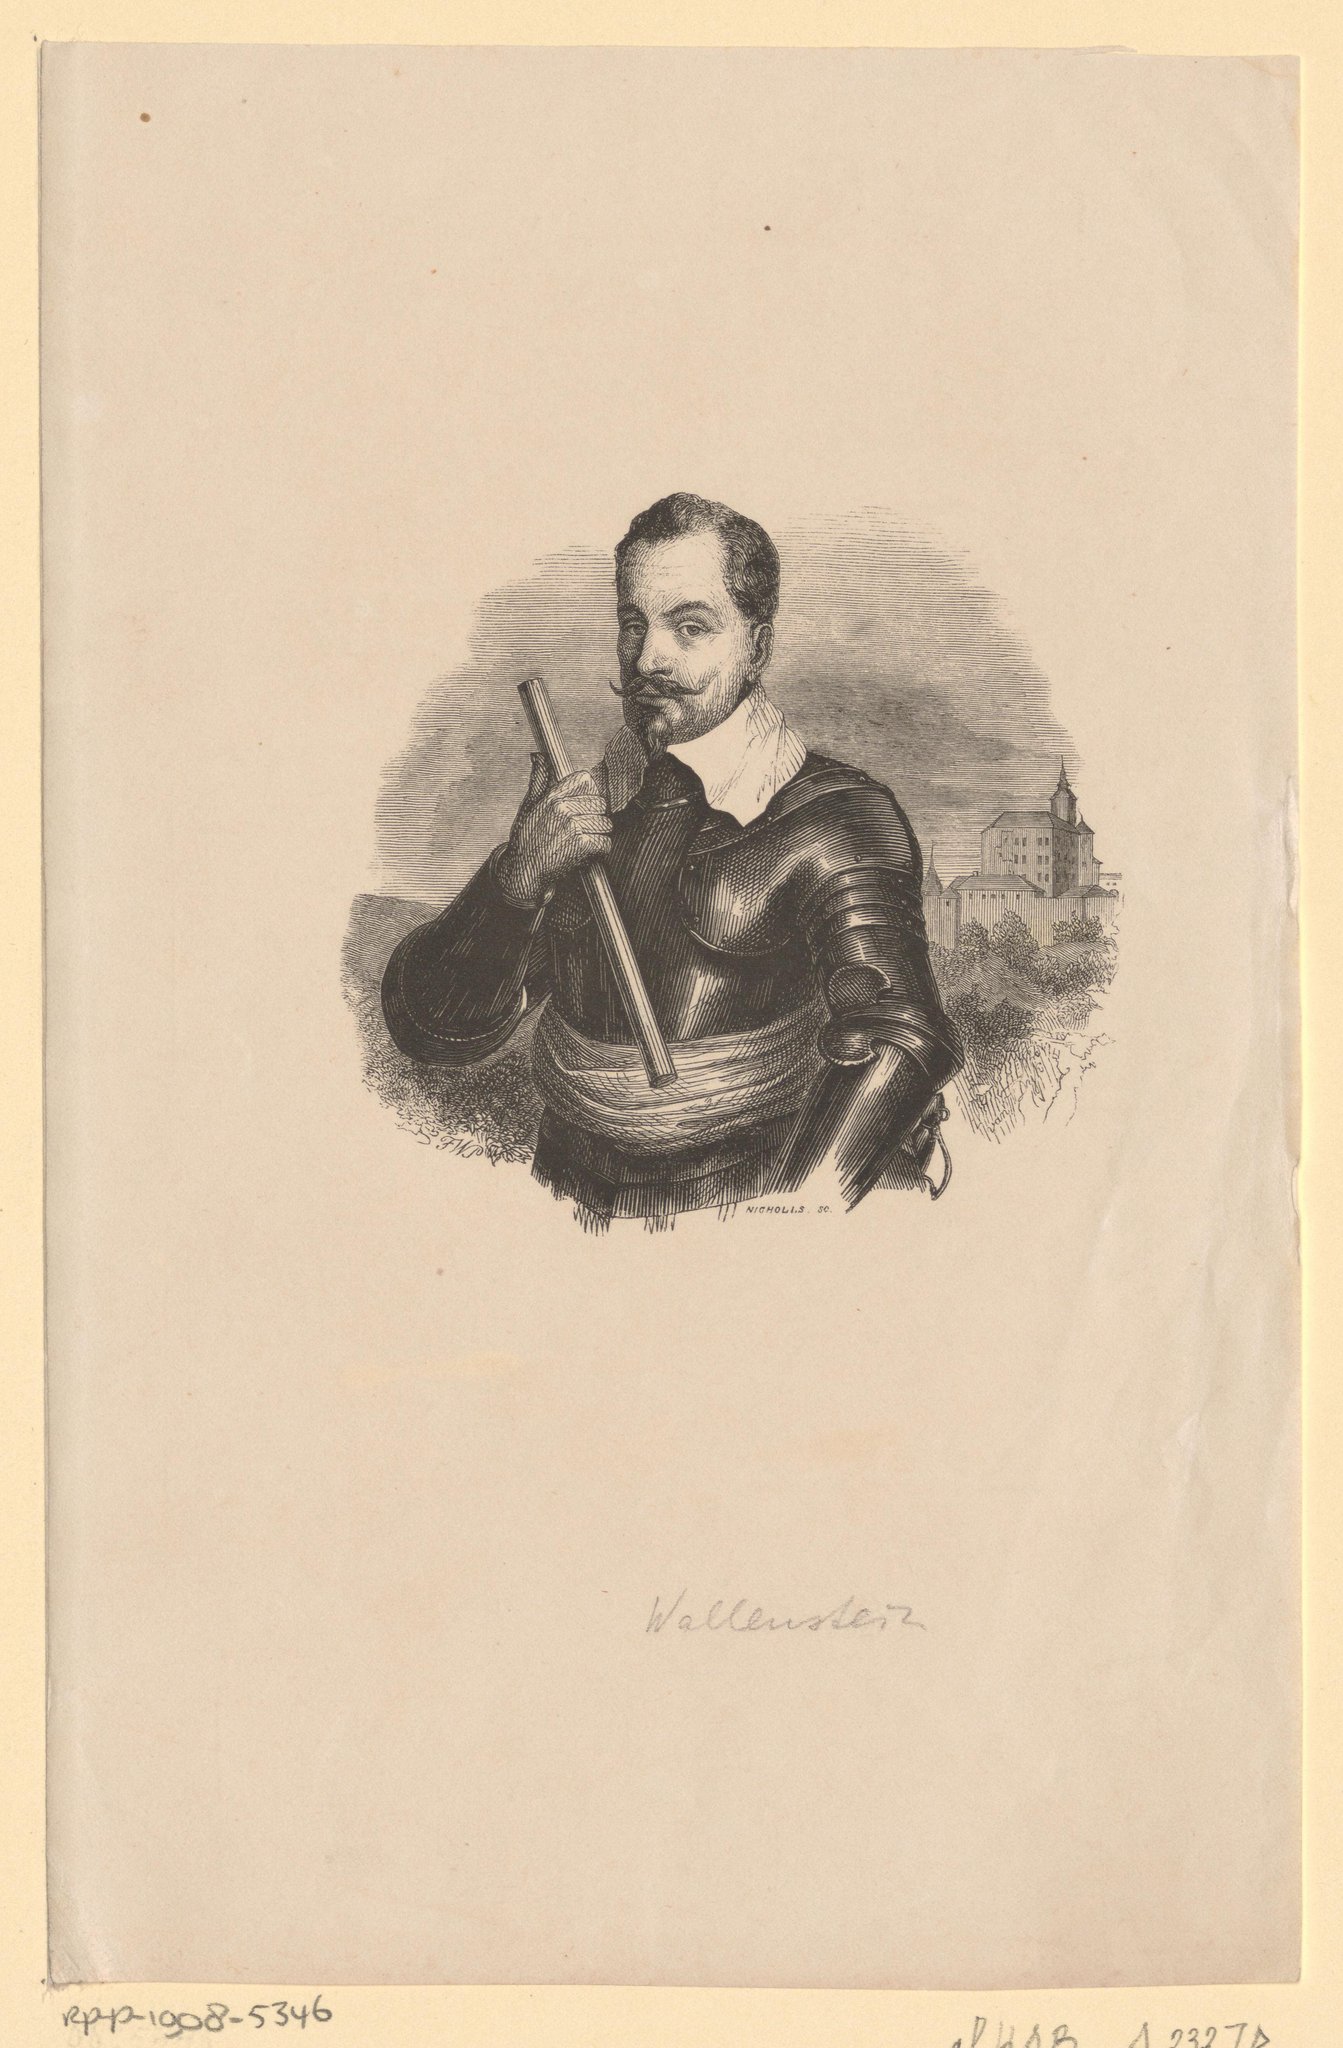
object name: print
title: Portret van Albrecht von Wallenstein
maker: Anonymous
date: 1866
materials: paper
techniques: engraving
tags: commander-in-chief, general, marshal, armour, historical persons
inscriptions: signature: ‘Nicholls Sc.’, collector's mark: Lugt 2228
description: Prent met tekst op verso gebruikt in: Wochenblatt für das christiche Volk, 11 november 1866.